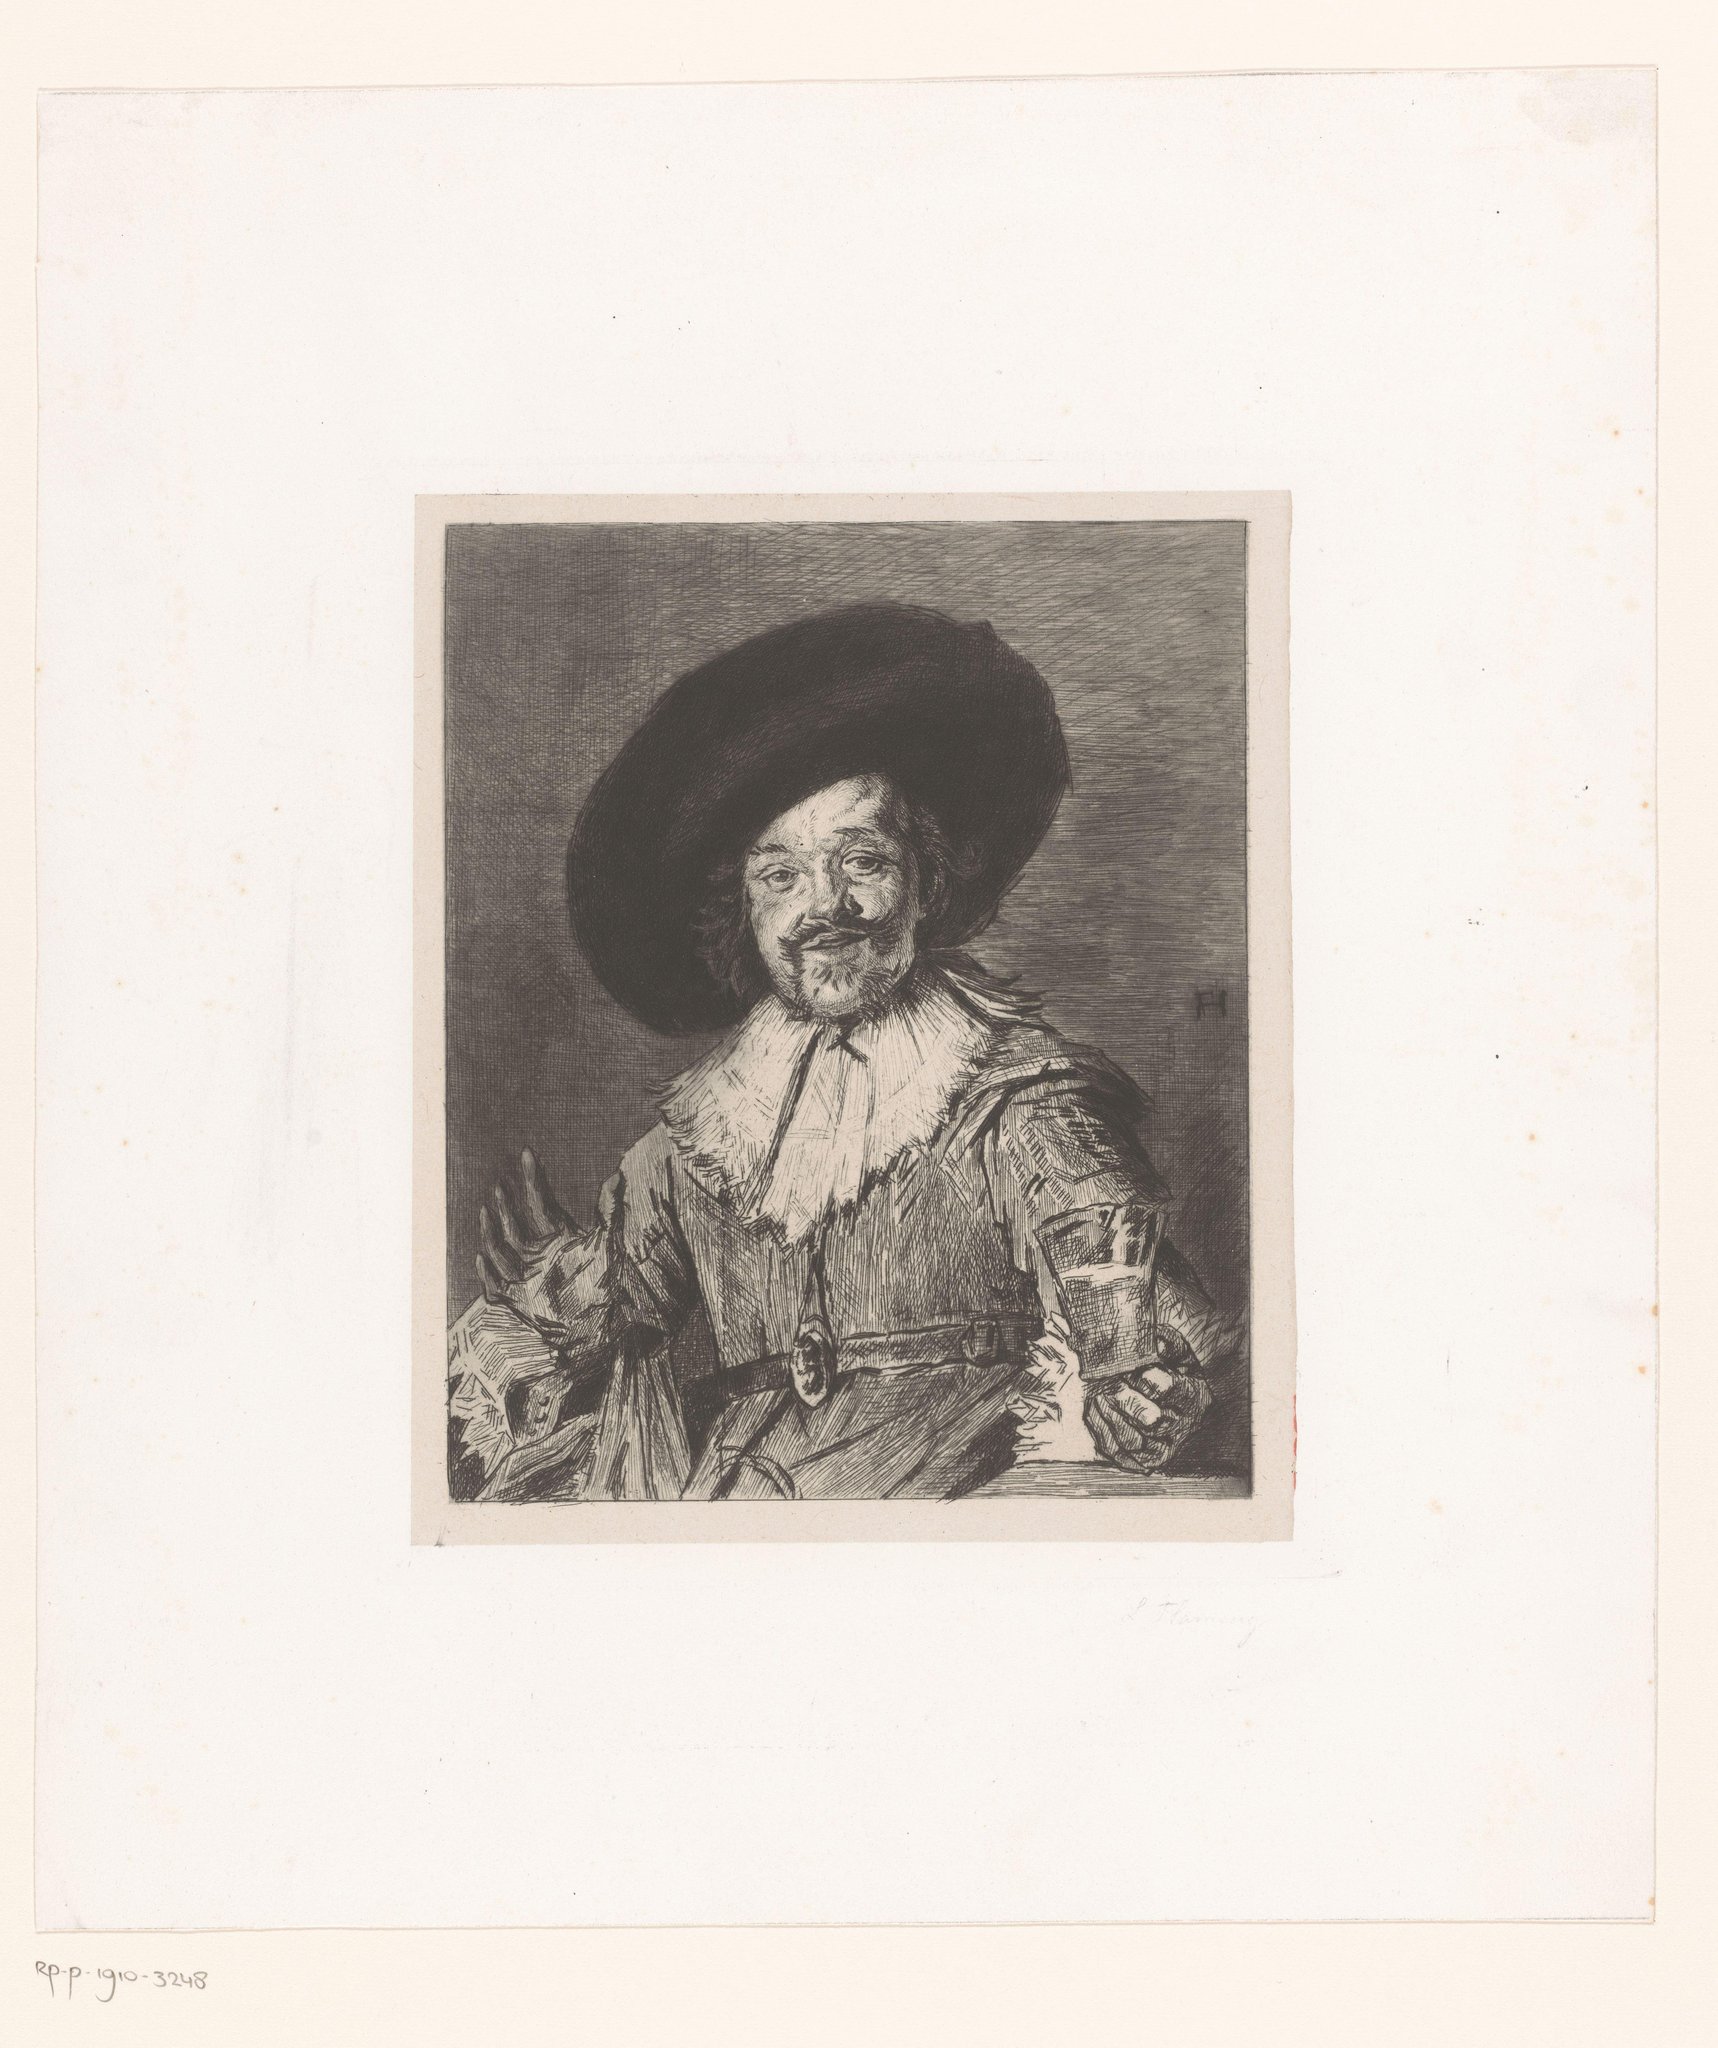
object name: print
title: Schutter die een berkenmeier vasthoudt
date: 1841-1910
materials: paper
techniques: drypoint, etching, intaglio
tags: anonymous historical person portrayed alone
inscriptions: collector's mark: Lugt 2228